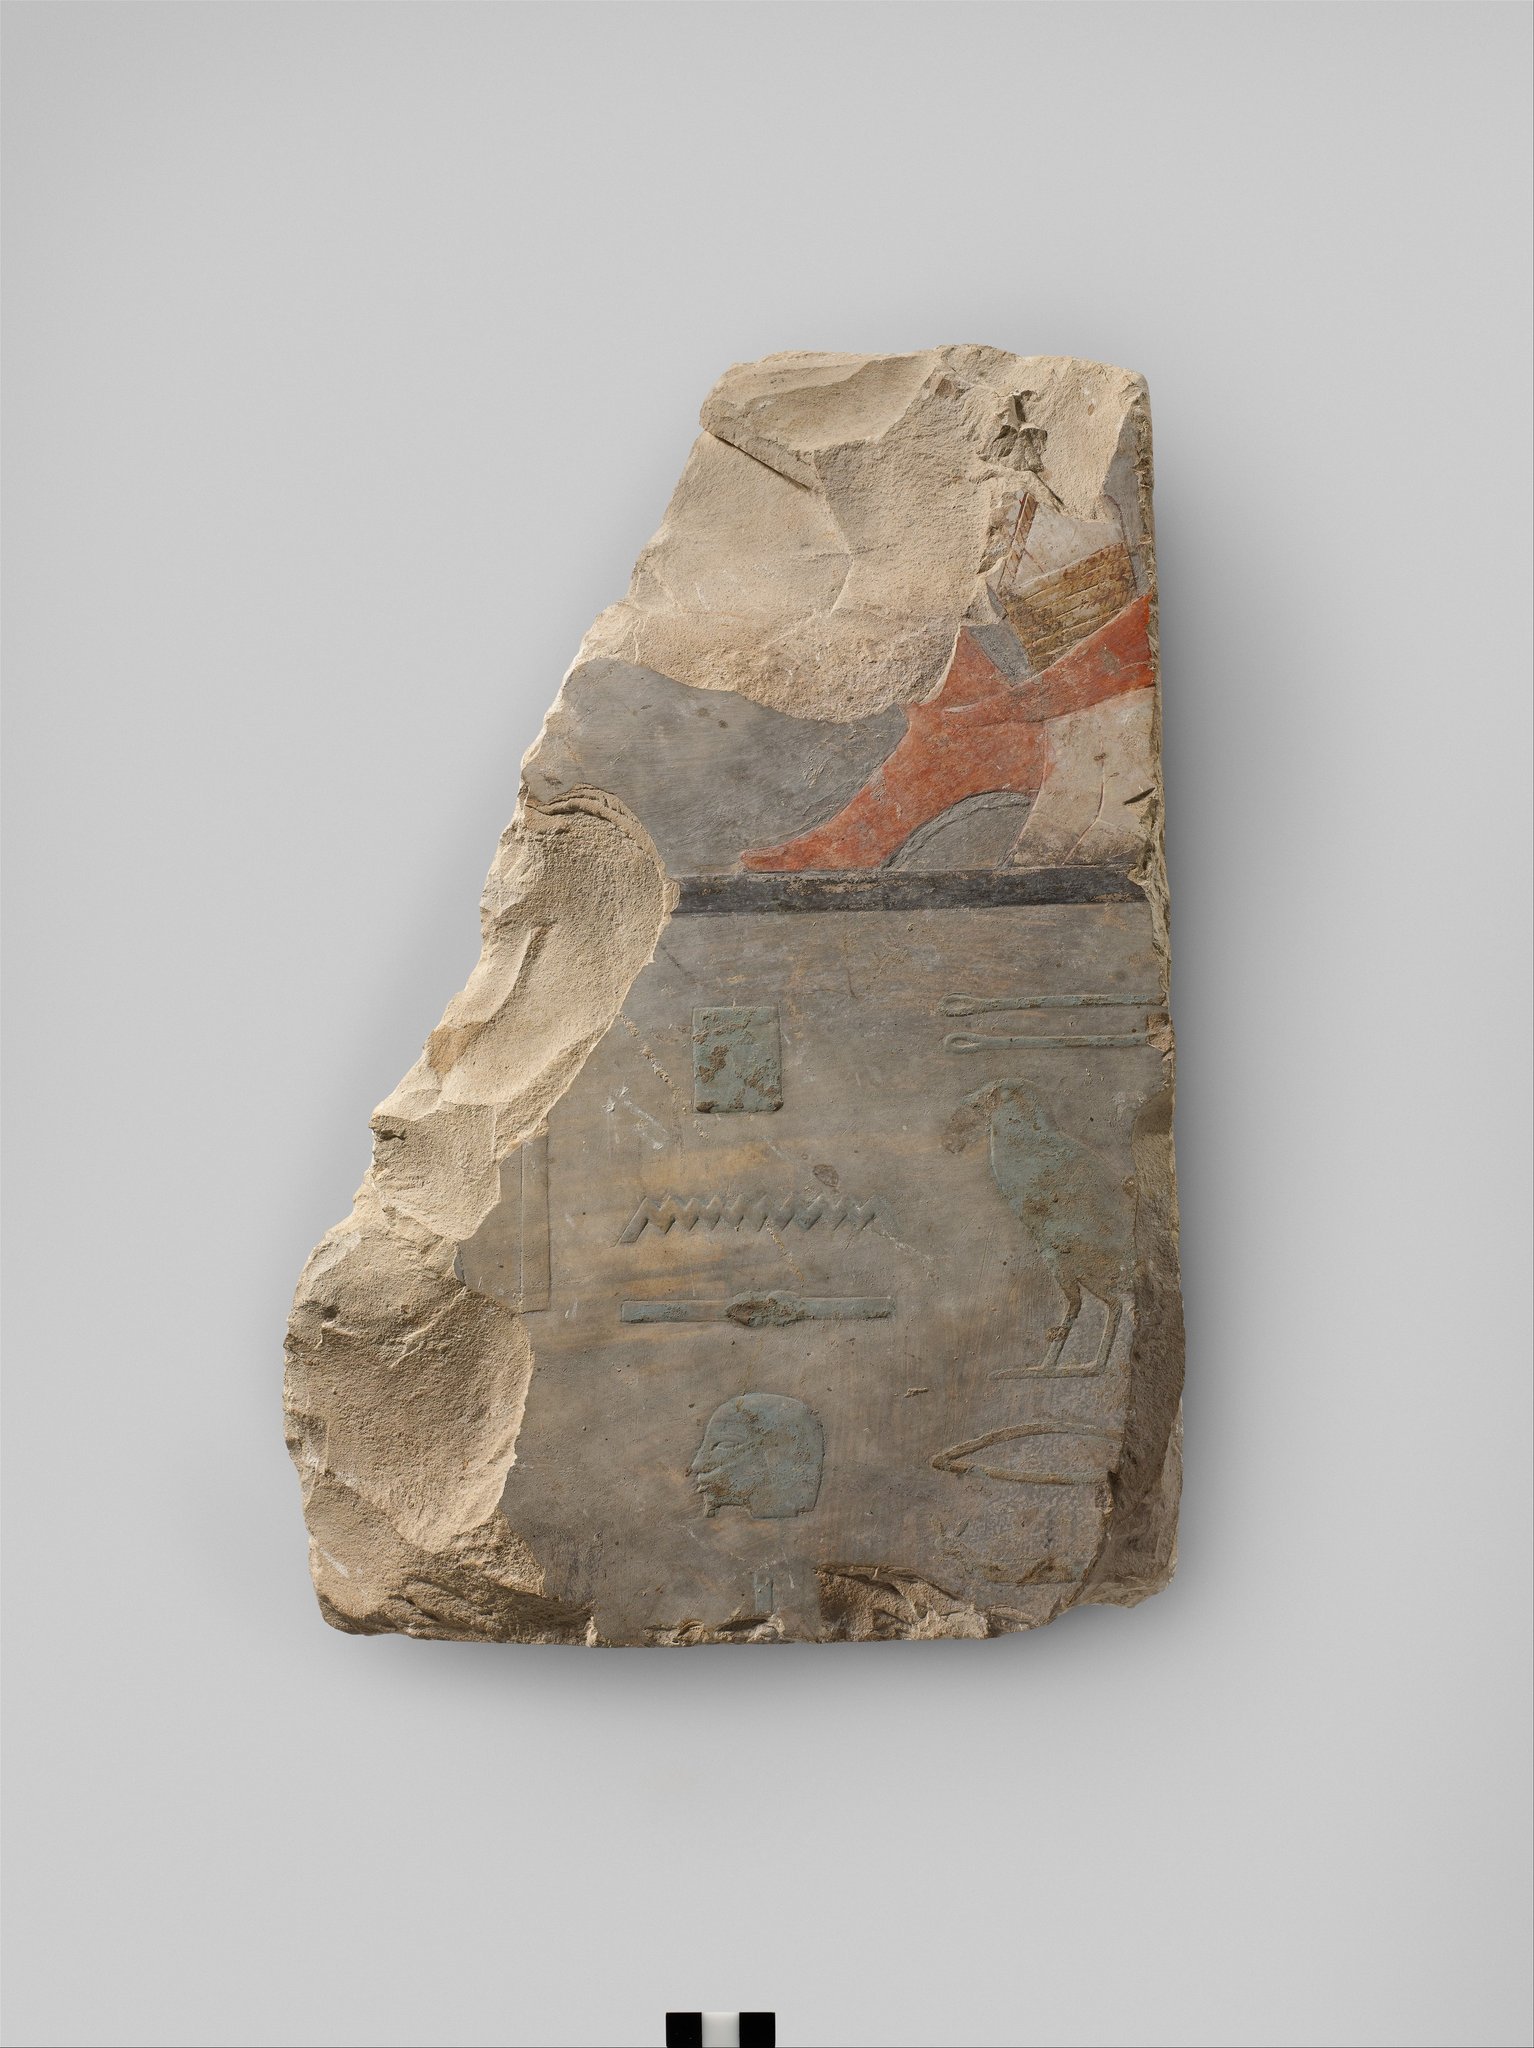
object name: relief fragment, tomb of meketre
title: Relief fragment from tomb of Meketre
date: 1981-1975 BCE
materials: limestone, paint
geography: egypt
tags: hieroglyphs